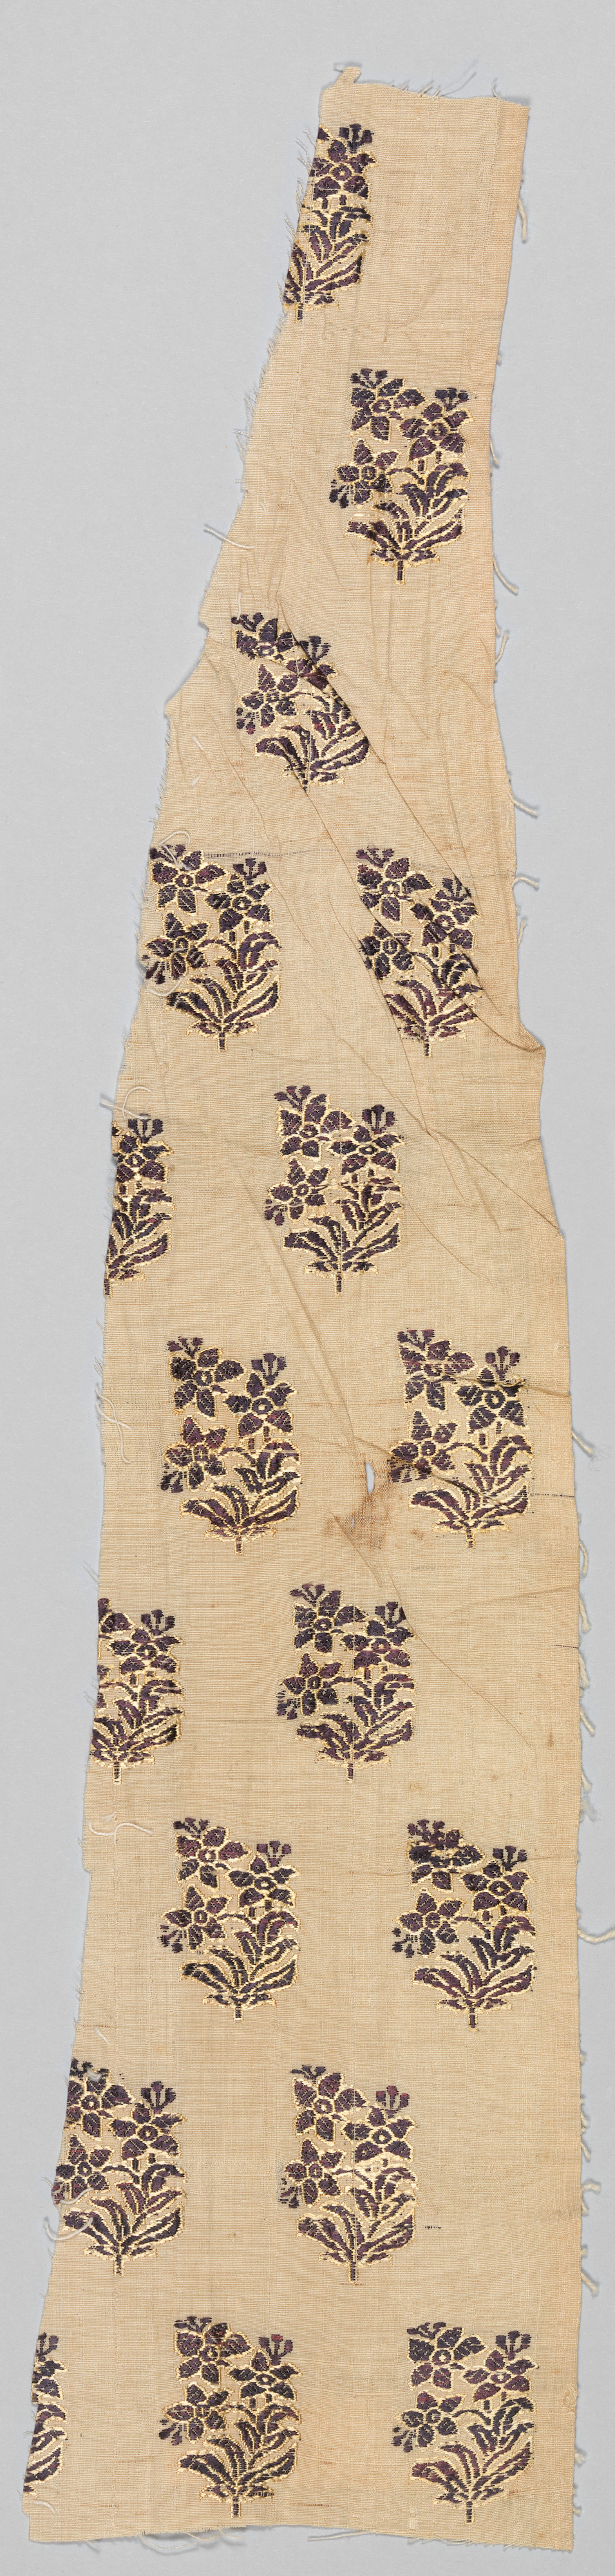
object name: textile fragment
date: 1701-1800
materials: metal thread, silk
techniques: brocade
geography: india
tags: flowers